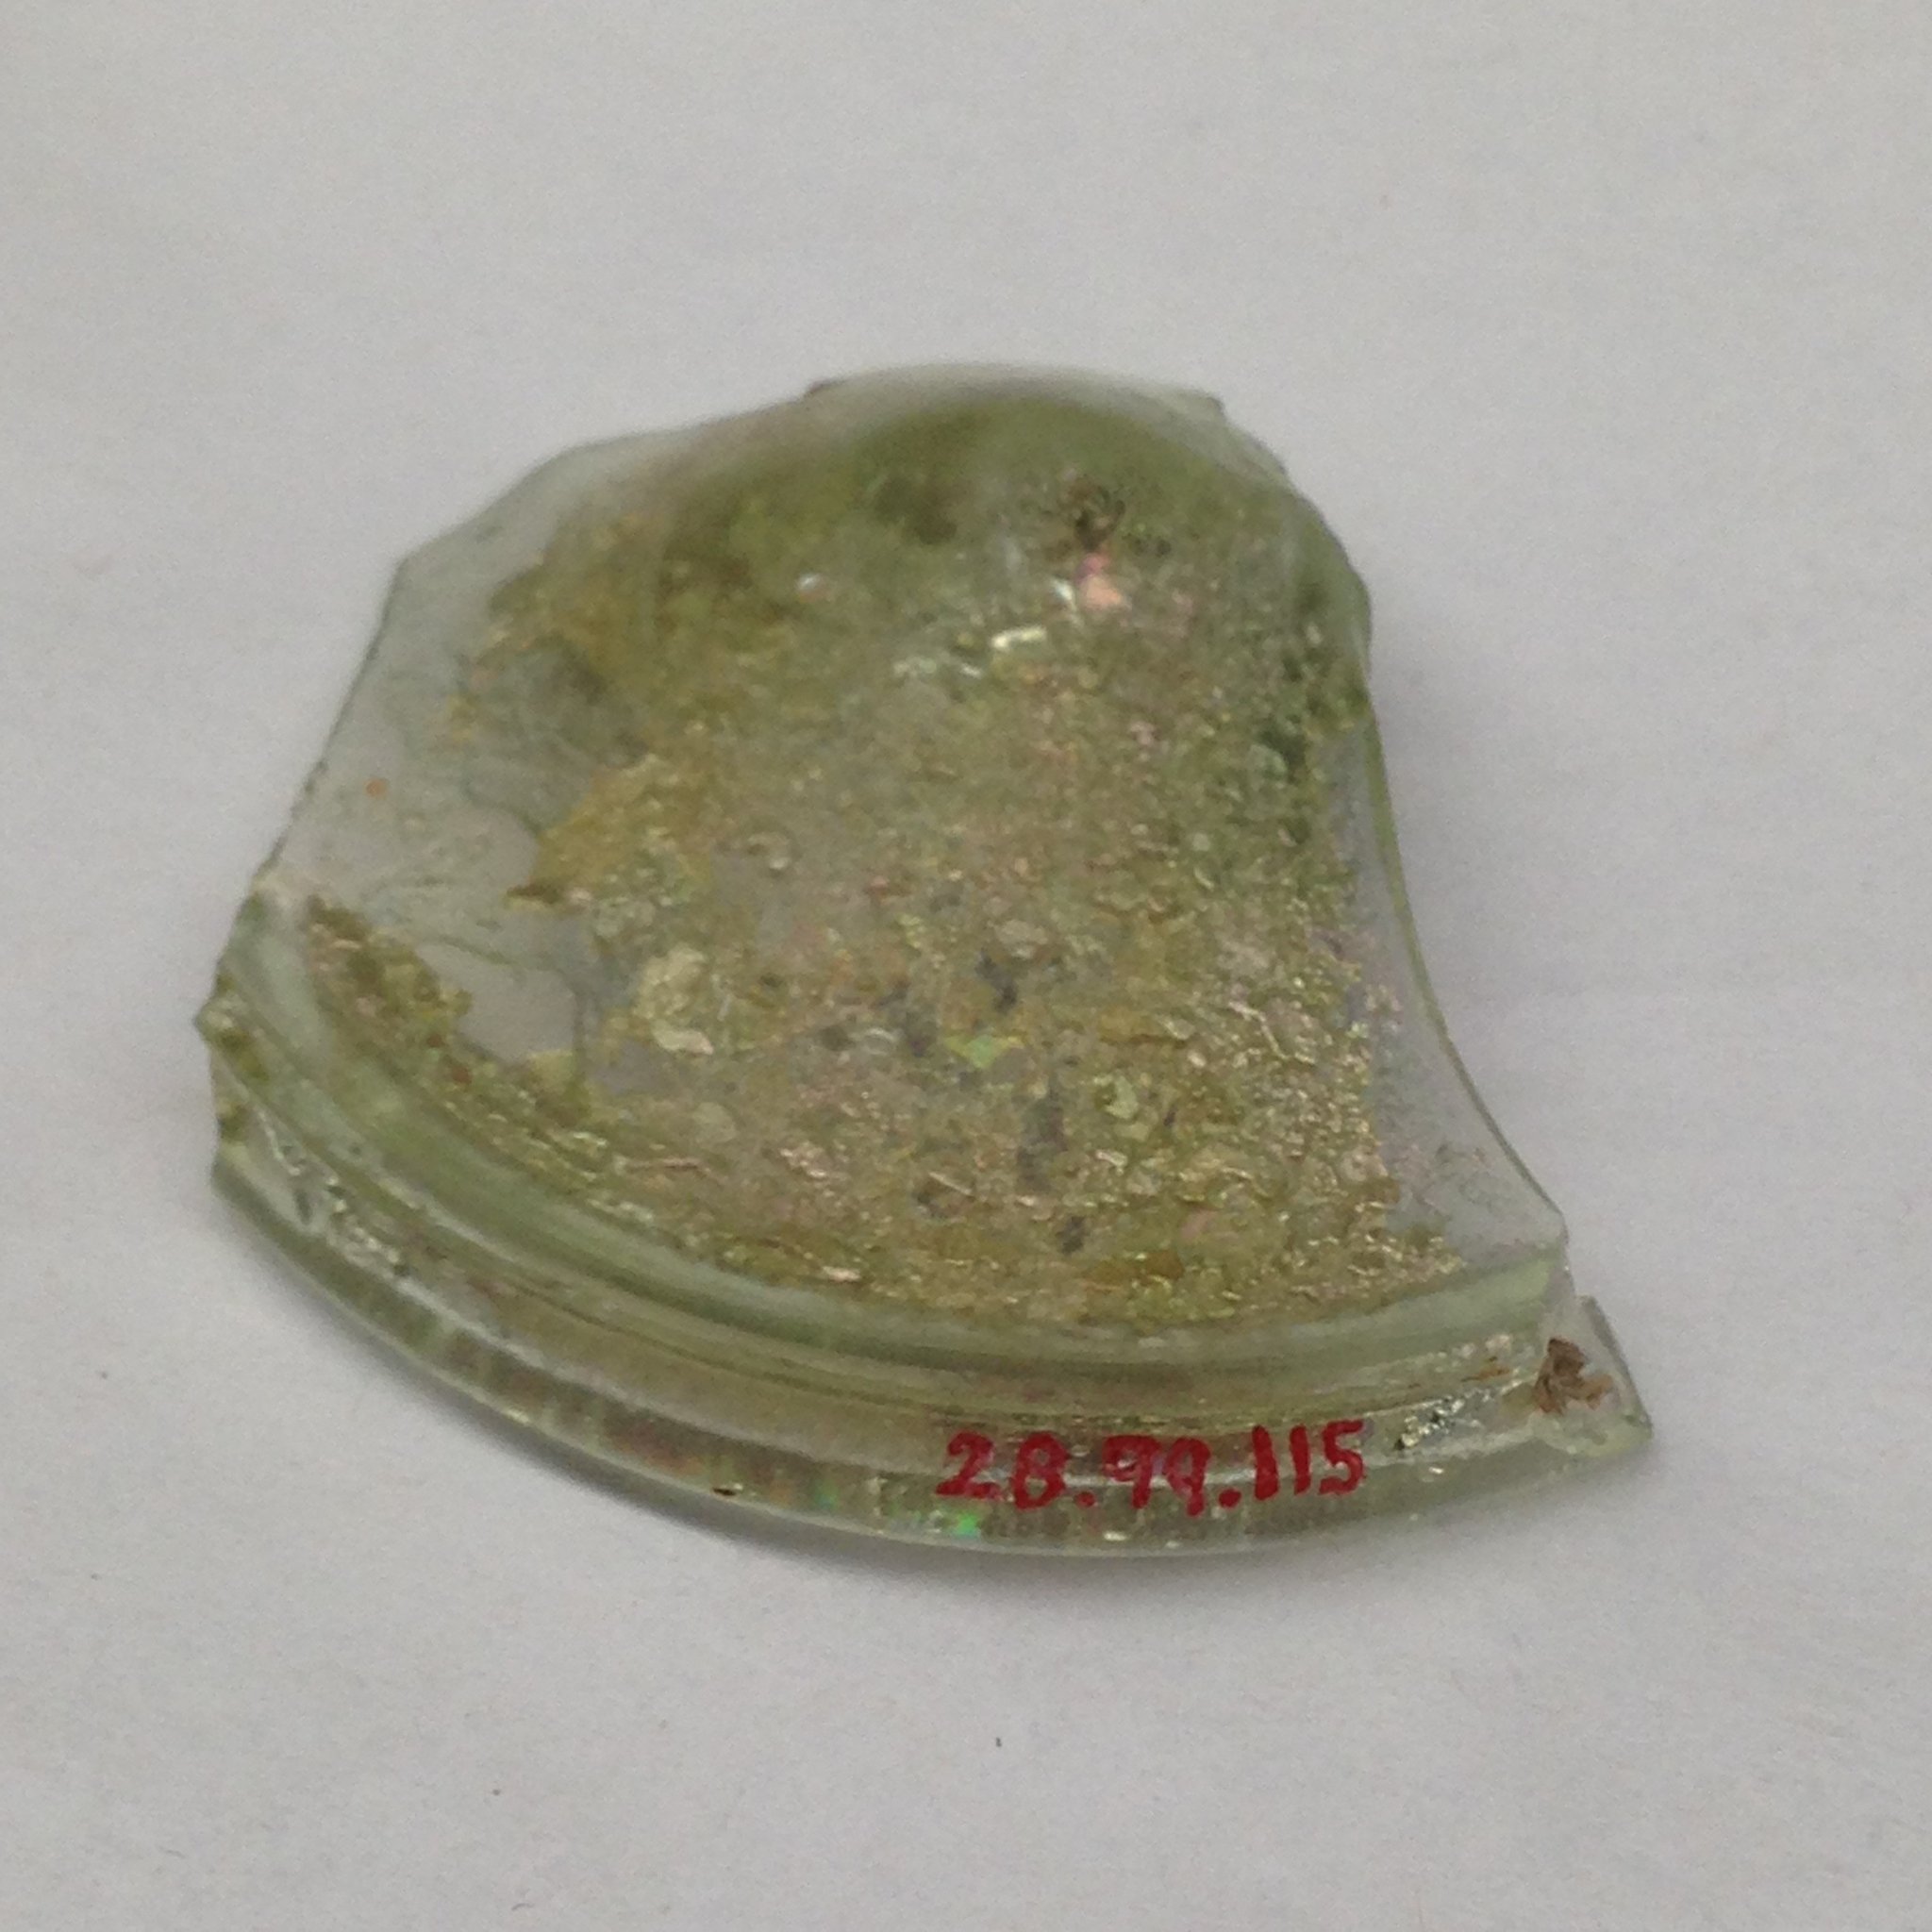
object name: fragment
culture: european or middle eastern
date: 1150-1250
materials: ceramic, glass